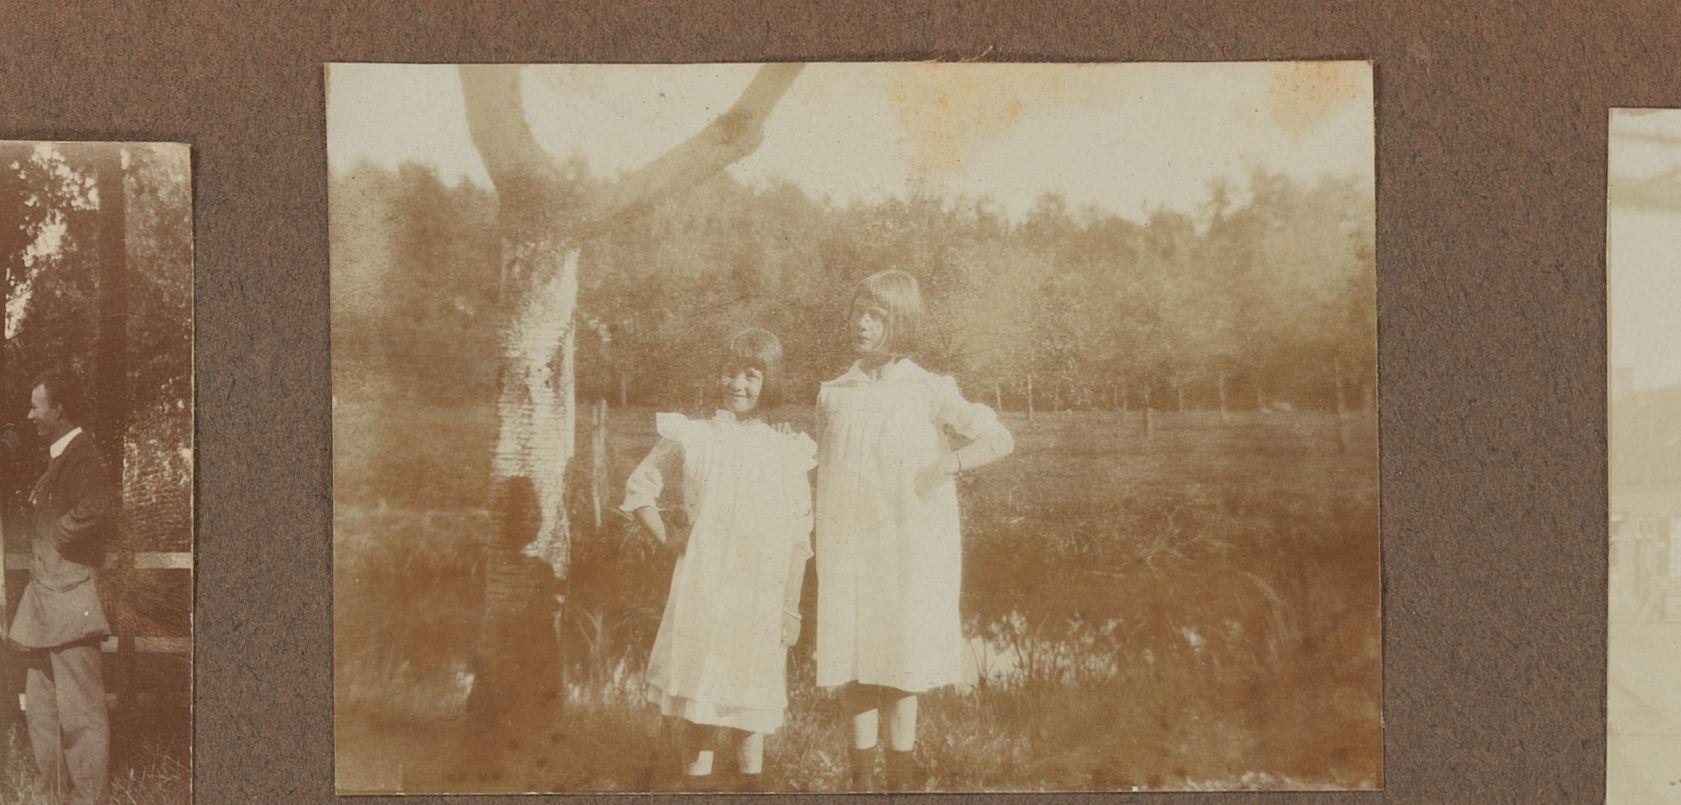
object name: photograph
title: Twee meisjes in veld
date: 1908-1915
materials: photographic support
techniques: photography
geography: netherlands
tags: netherlands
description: Foto op bruin albumblad 48 van familiealbum van Alphons Diepenbrock.